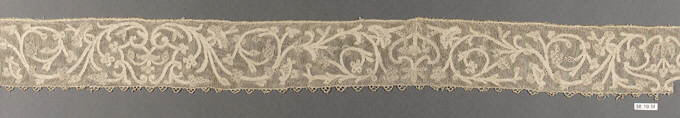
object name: hebrew ritual lace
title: Hebrew ritual lace (one of four)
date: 1701-1733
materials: silk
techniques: lace